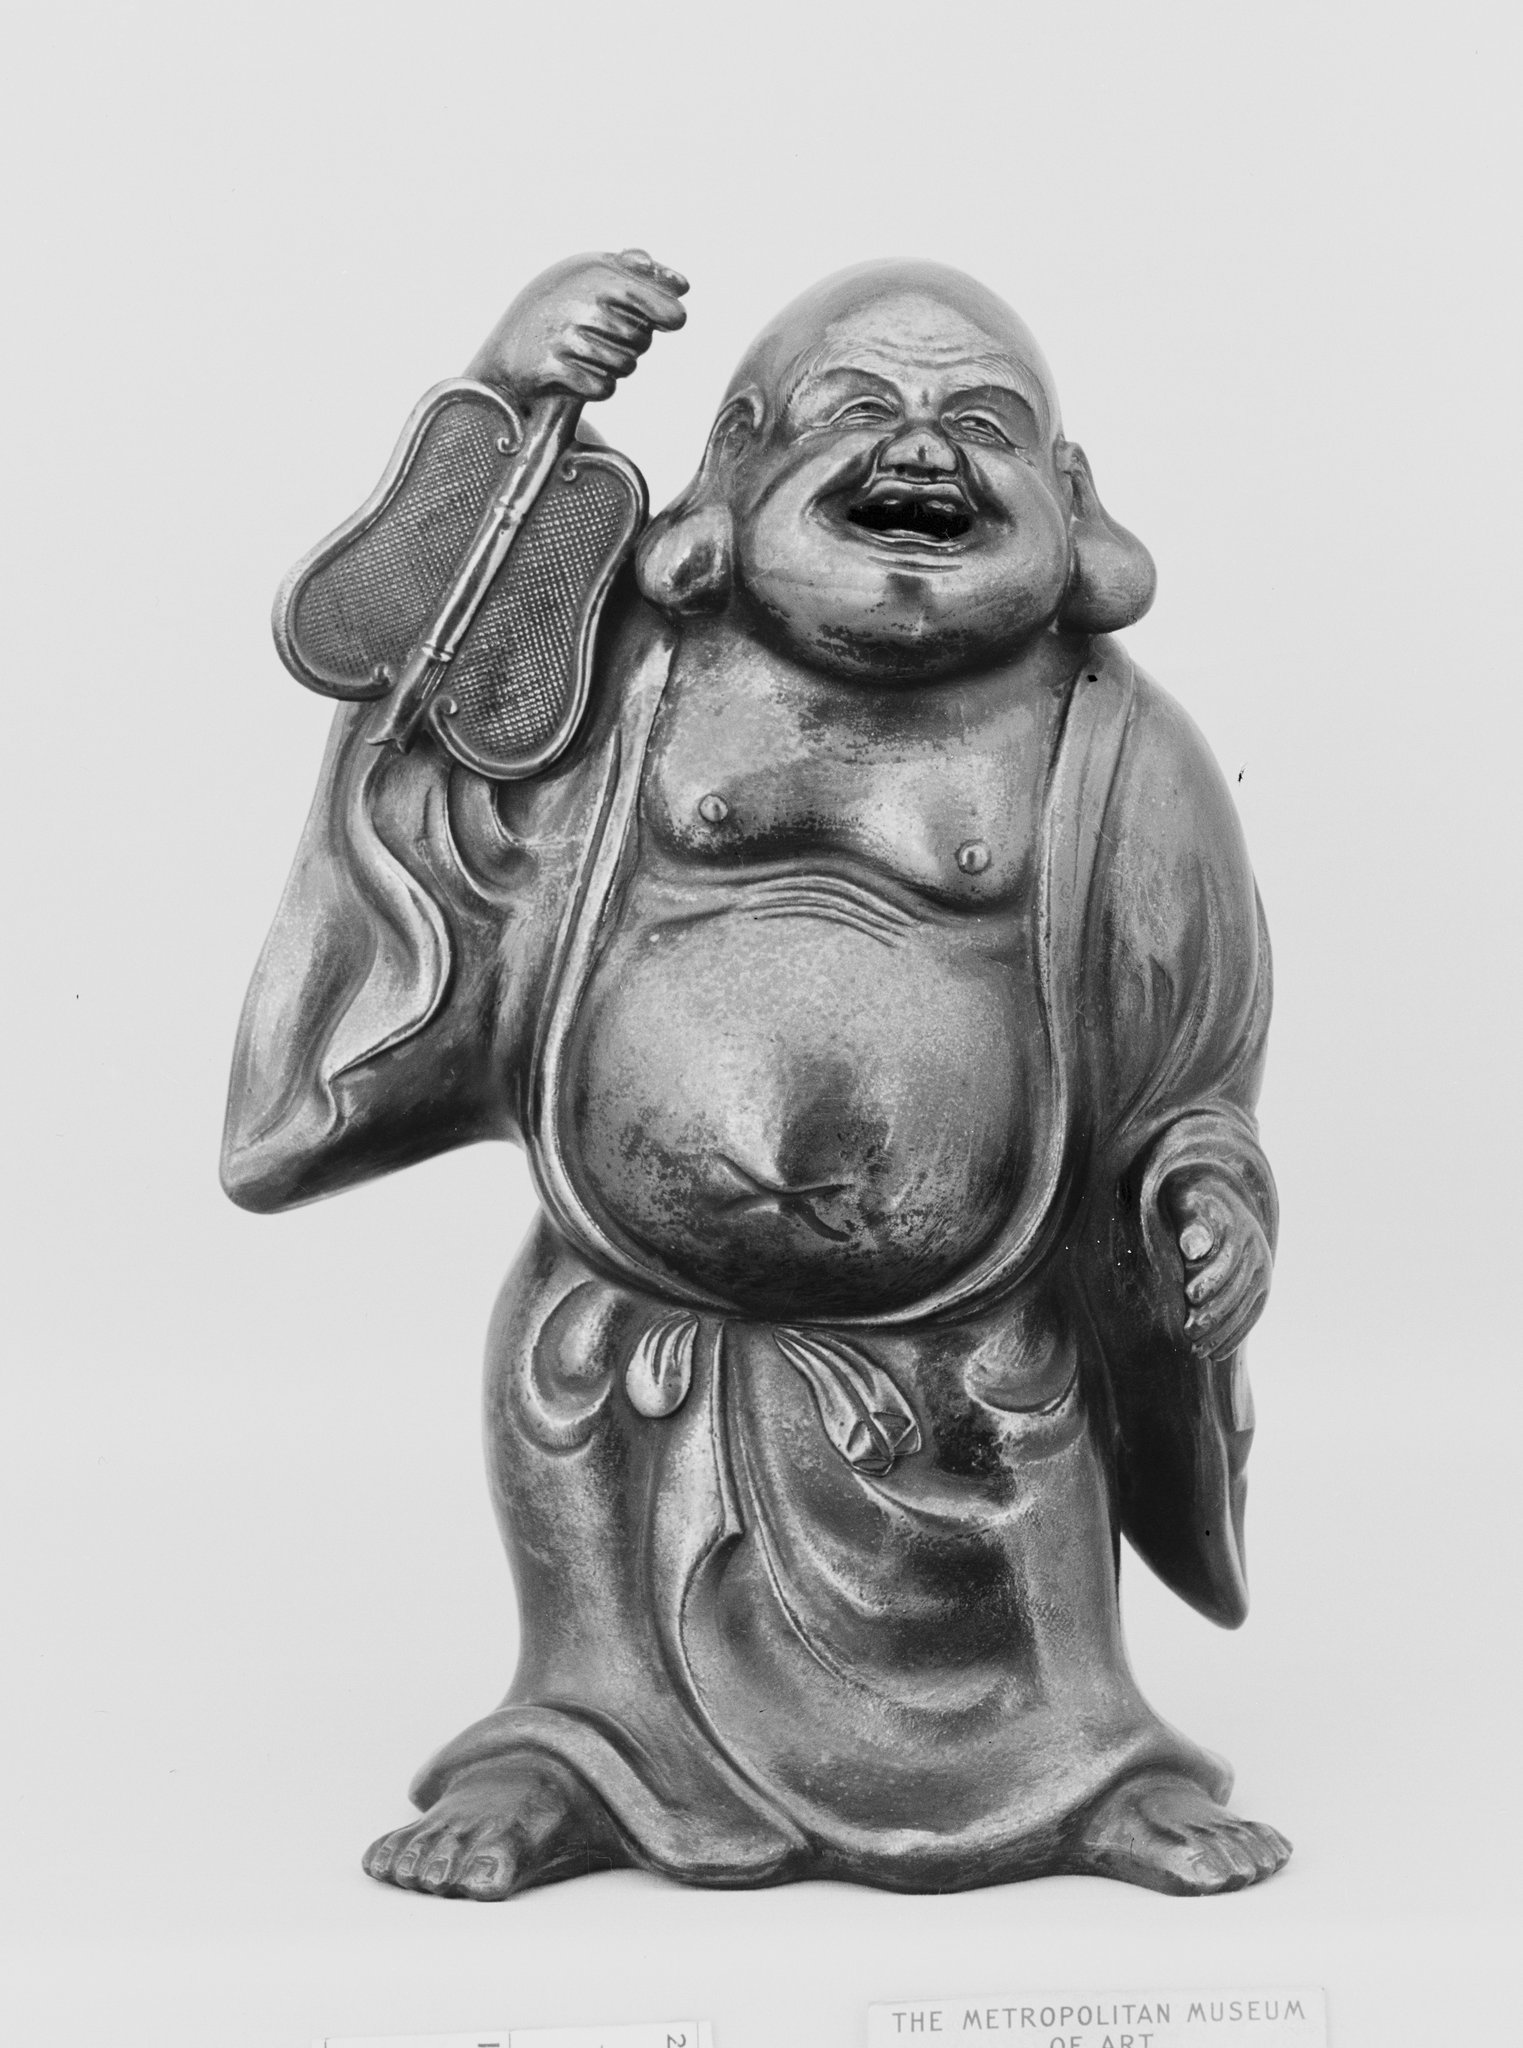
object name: figure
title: Figure of Hotei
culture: japanese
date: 1701-1800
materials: clay, glaze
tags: men